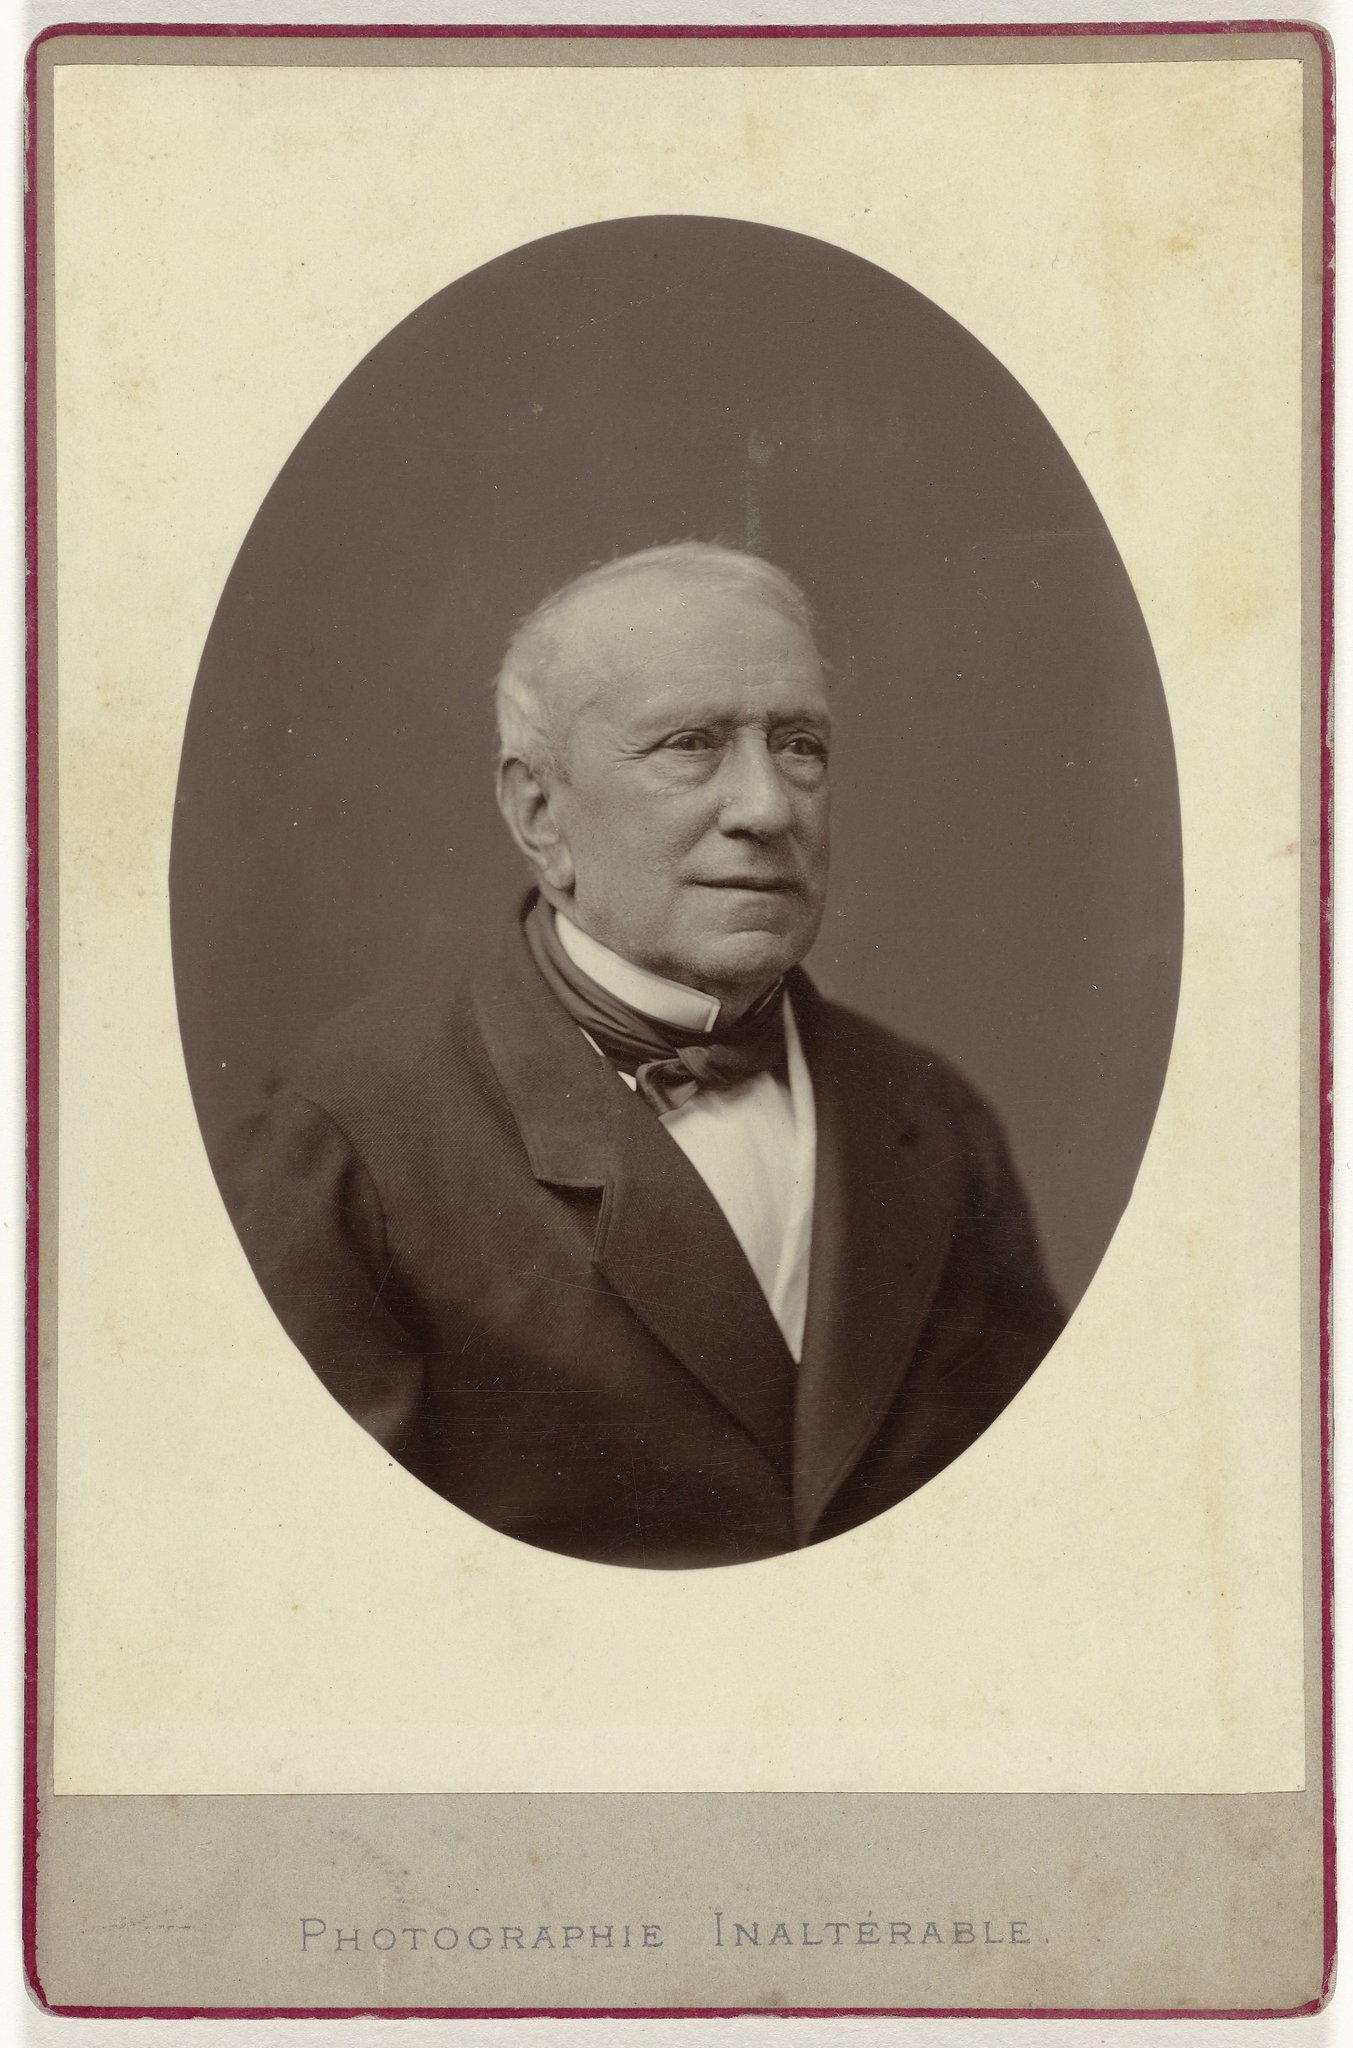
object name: cabinet photograph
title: Portret van Edouard Mussche, Rue Bredrode 11 Brussel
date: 1875-1880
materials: cardboard, photographic support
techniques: carbon print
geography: brussels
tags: historical persons